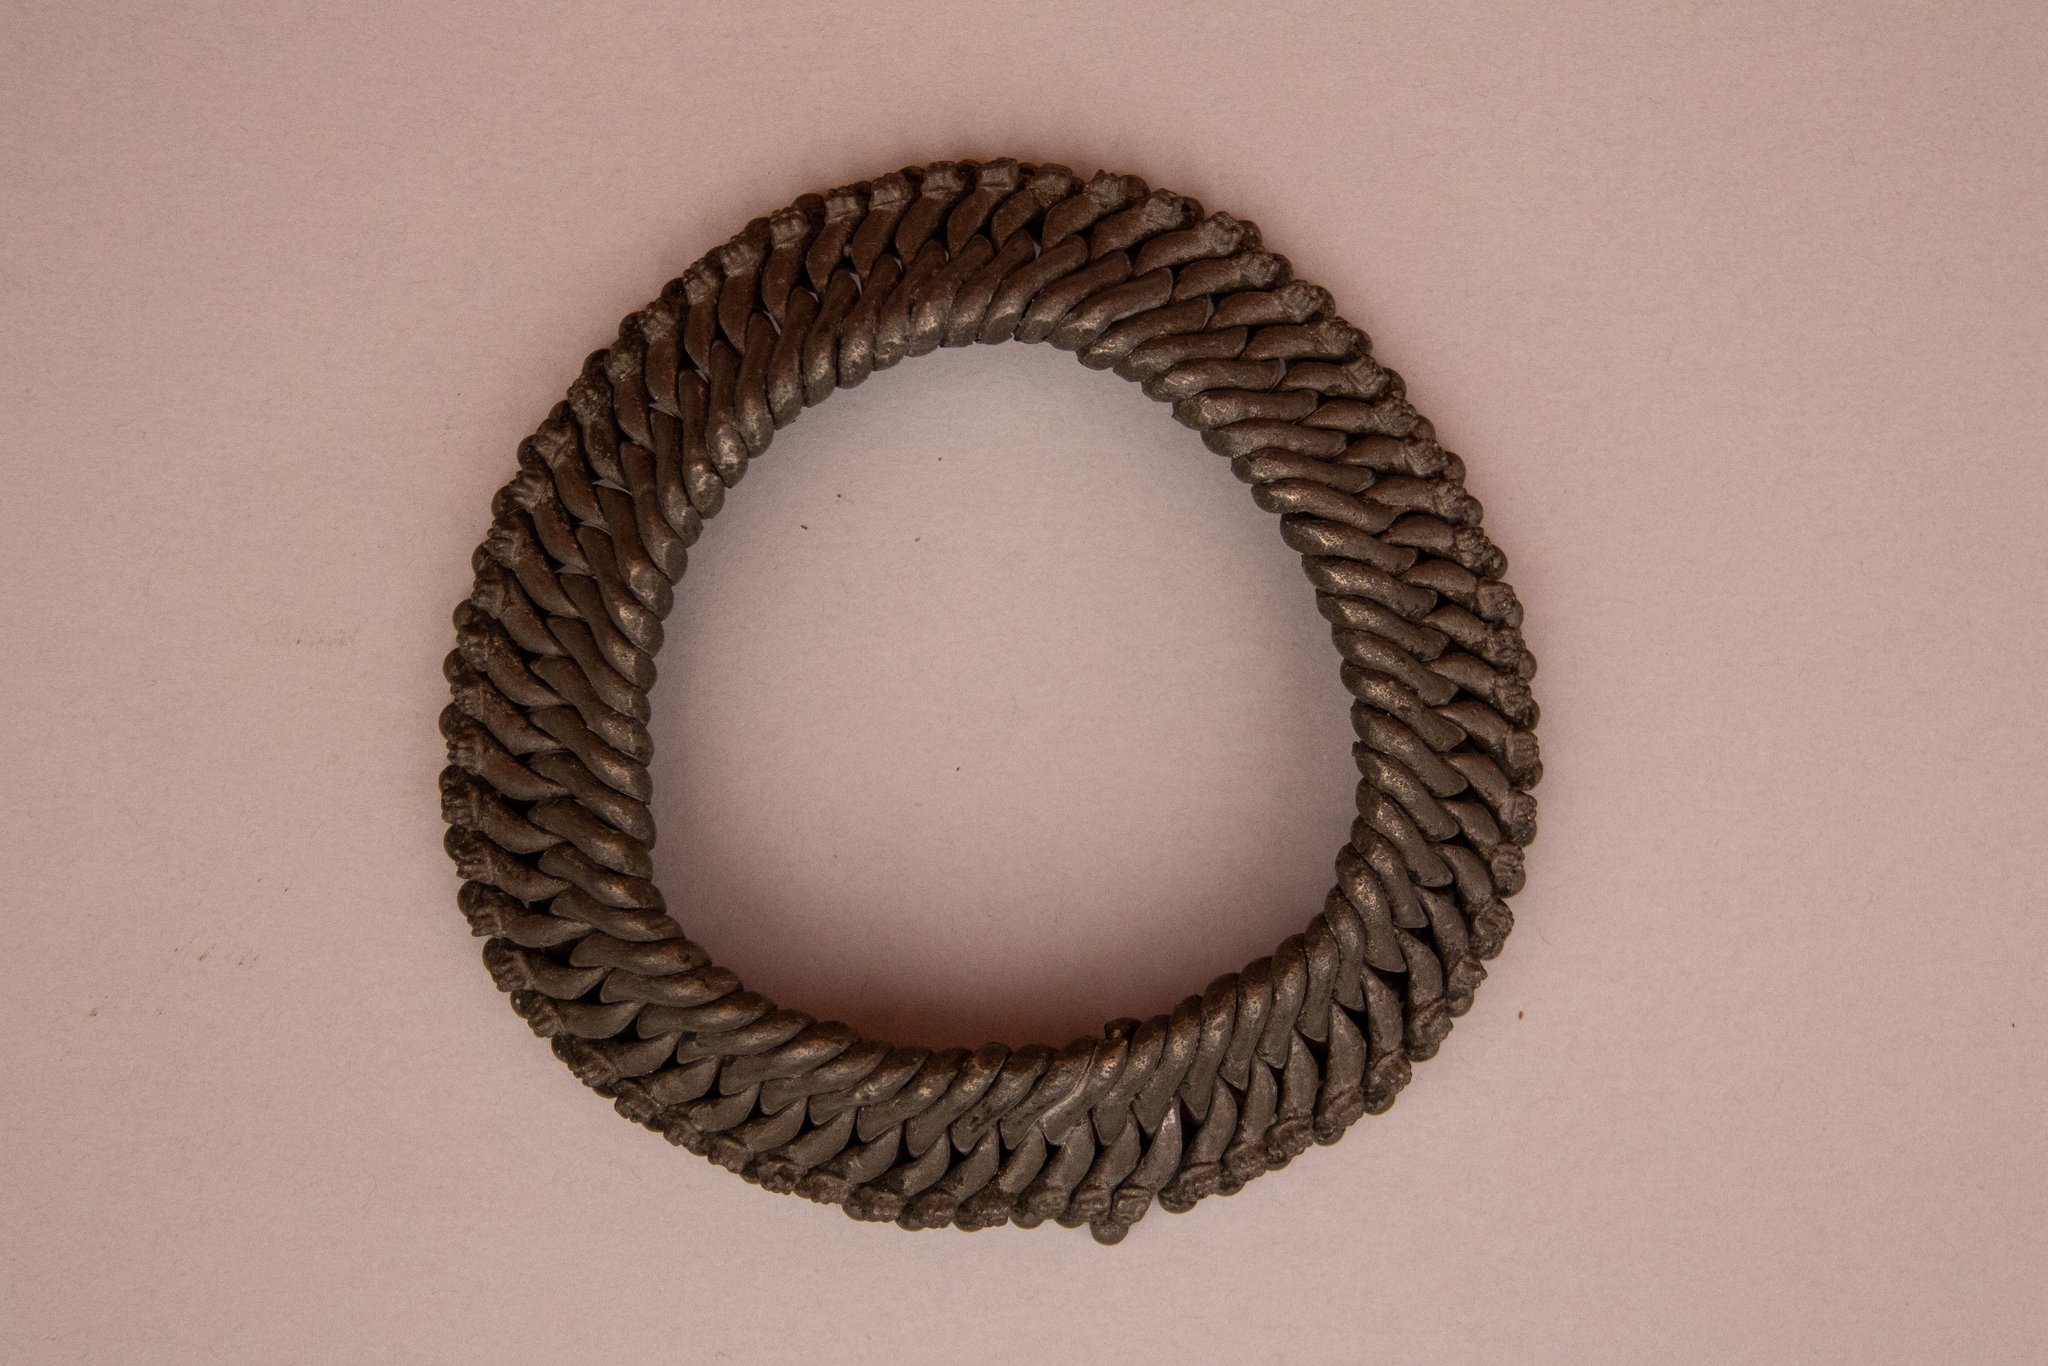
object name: bracelet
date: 1801-1900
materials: metal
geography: central india